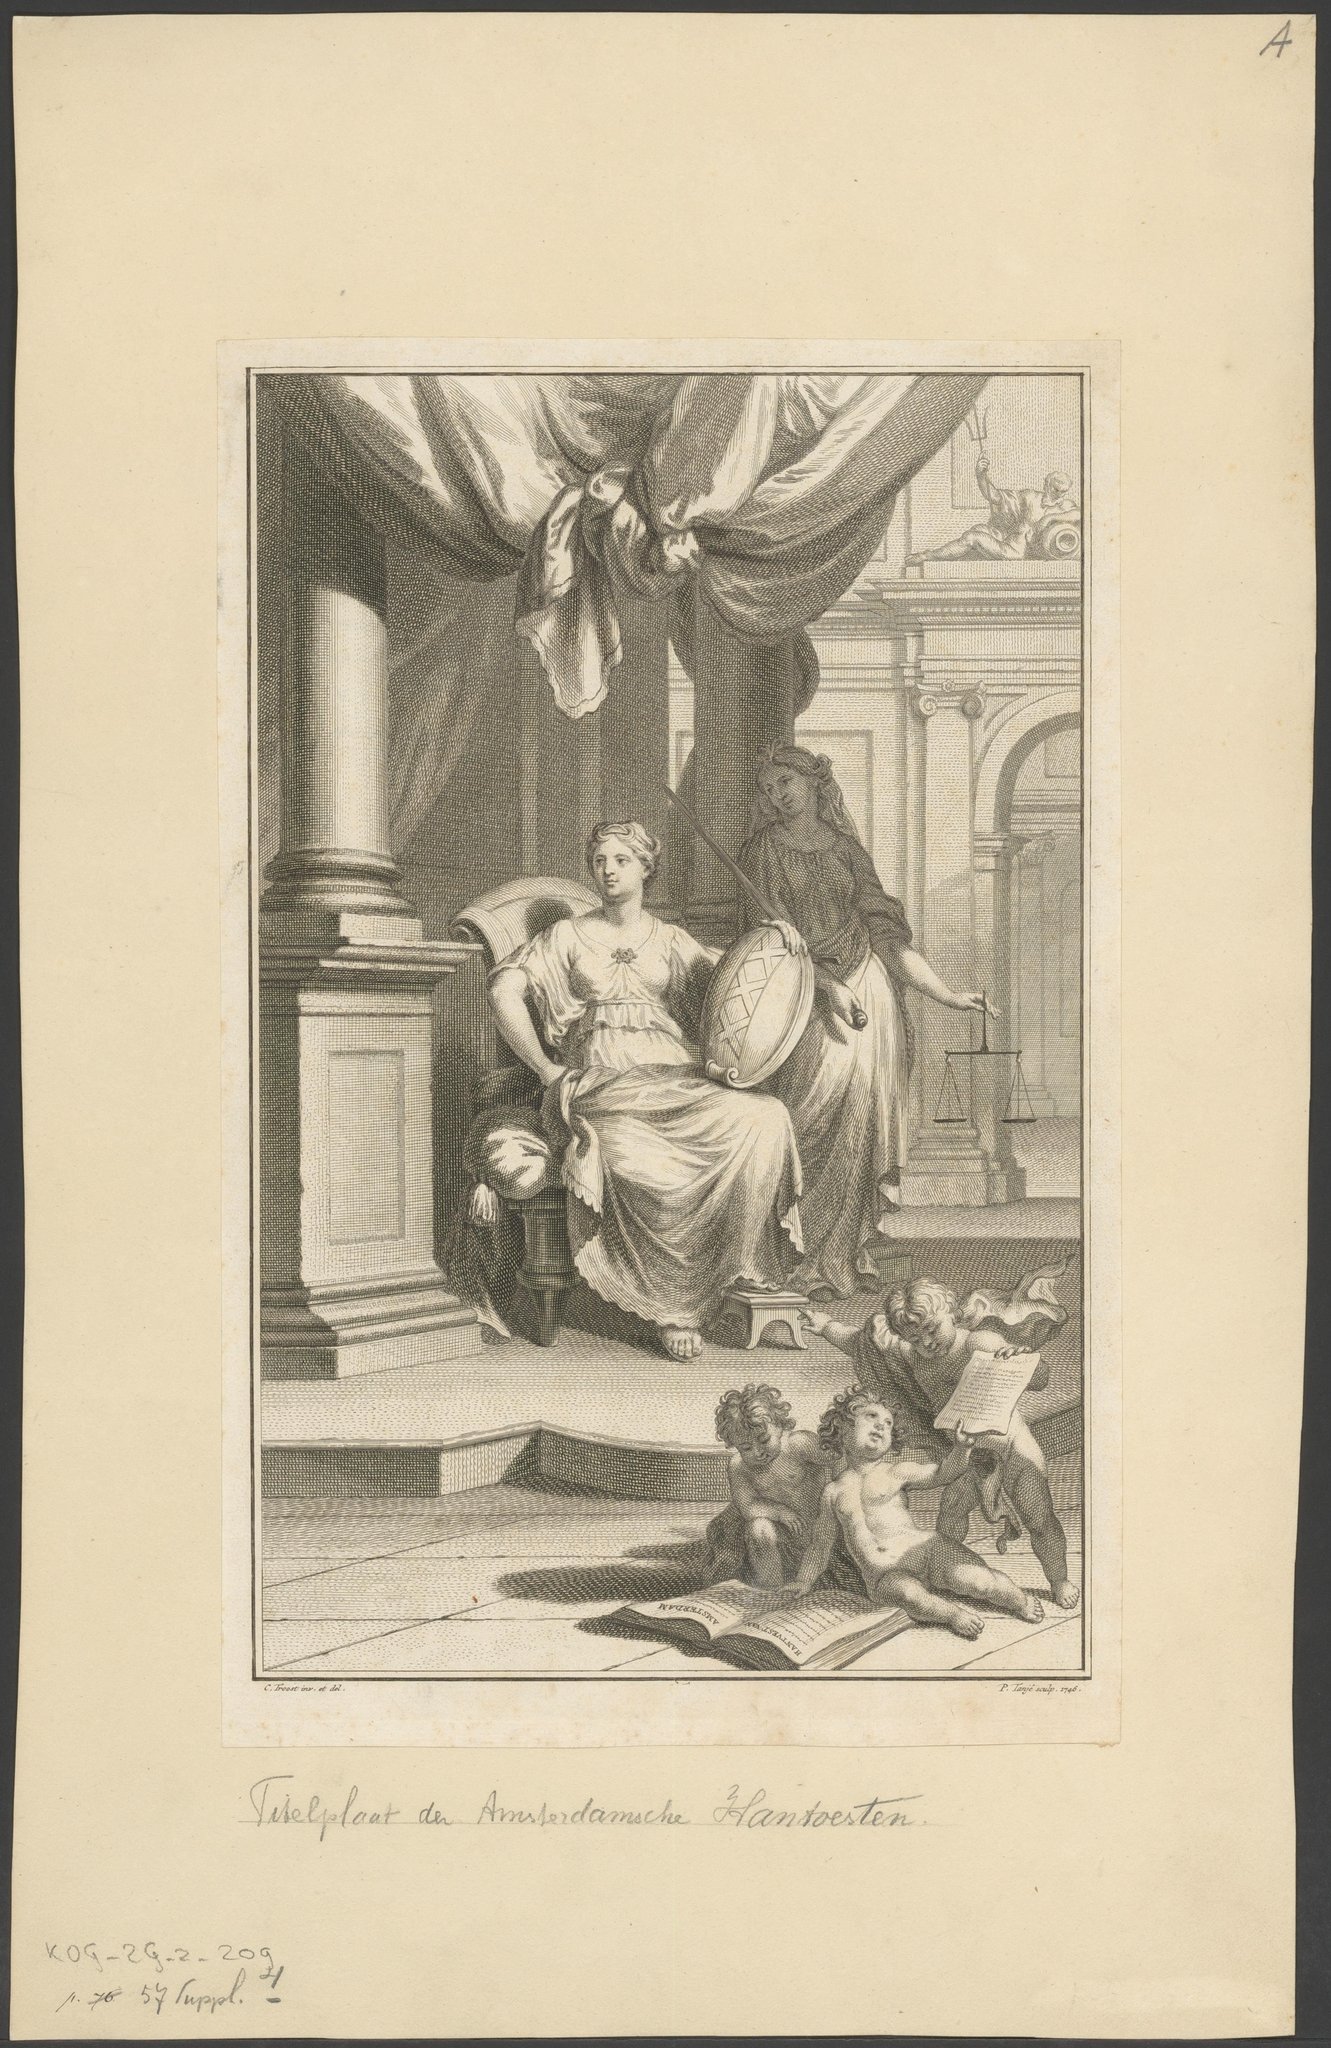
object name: titelblad, titelpagina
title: Titelpagina voor: Handvesten; ofte privilegien ende octroyen (...) der stad Amstelredam, 1748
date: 1746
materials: paper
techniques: engraving, etching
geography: amsterdam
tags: justice, 'justitia'; 'giustitia divina' (ripa) ~ one of the four cardinal virtues, personification of a city, town-patron(ess), amsterdam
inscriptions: collector's mark: Lugt 2488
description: Titelpagina voor: Handvesten; ofte privilegien ende octroyen (...) der stad Amstelredam. 3 dln. Amsterdam: Hendrik Janssonius van Waesberge, Salomon Schouten, Petrus Schouten, 1748. Bij de prent een brief van de veilinghouder R.W.P. de Vries aan Alexander Ver Huell, 8 augustus 1873.